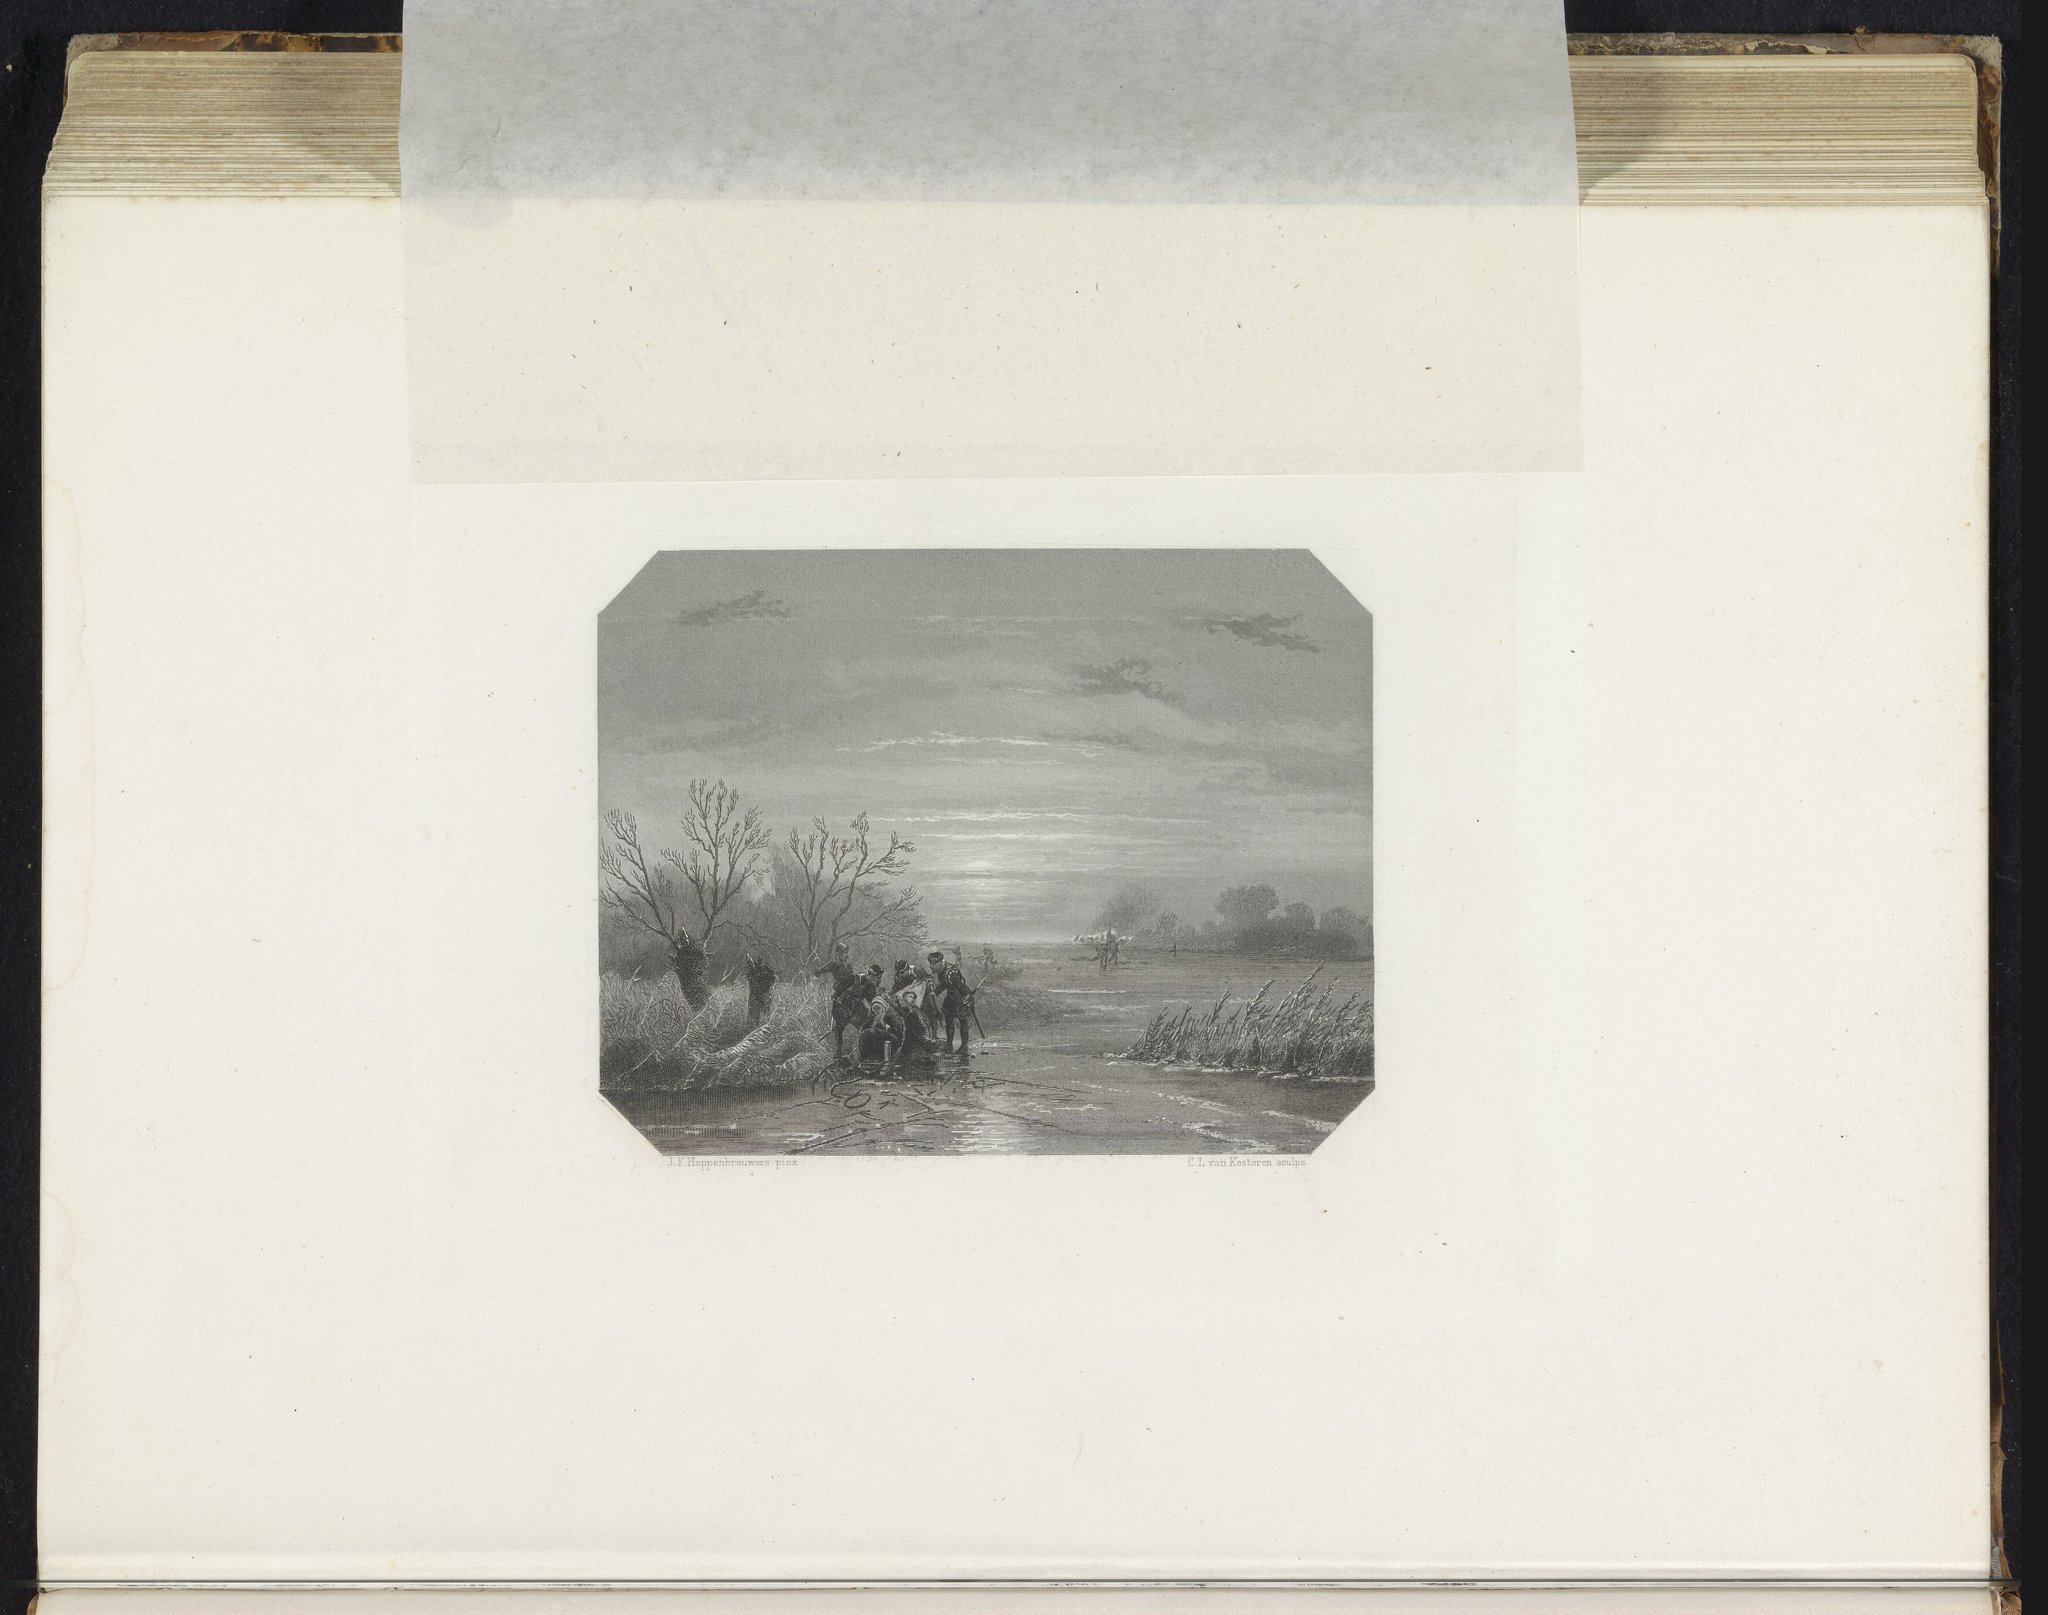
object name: print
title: Lammert Meliszooon van Westzanen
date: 1865-1870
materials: paper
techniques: engraving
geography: netherlands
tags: sleigh, sledge (non-sport)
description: De vlucht van Lambert Melisz. met zijn moeder over het ijs naar Hoorn, februari 1574. Onderweg worden zij door Spaanse soldaten aangehouden. Onderdeel van de groep staalgravures naar de schilderijen van de Historische Galerij der Maatschappij Arti et Amicitiae.